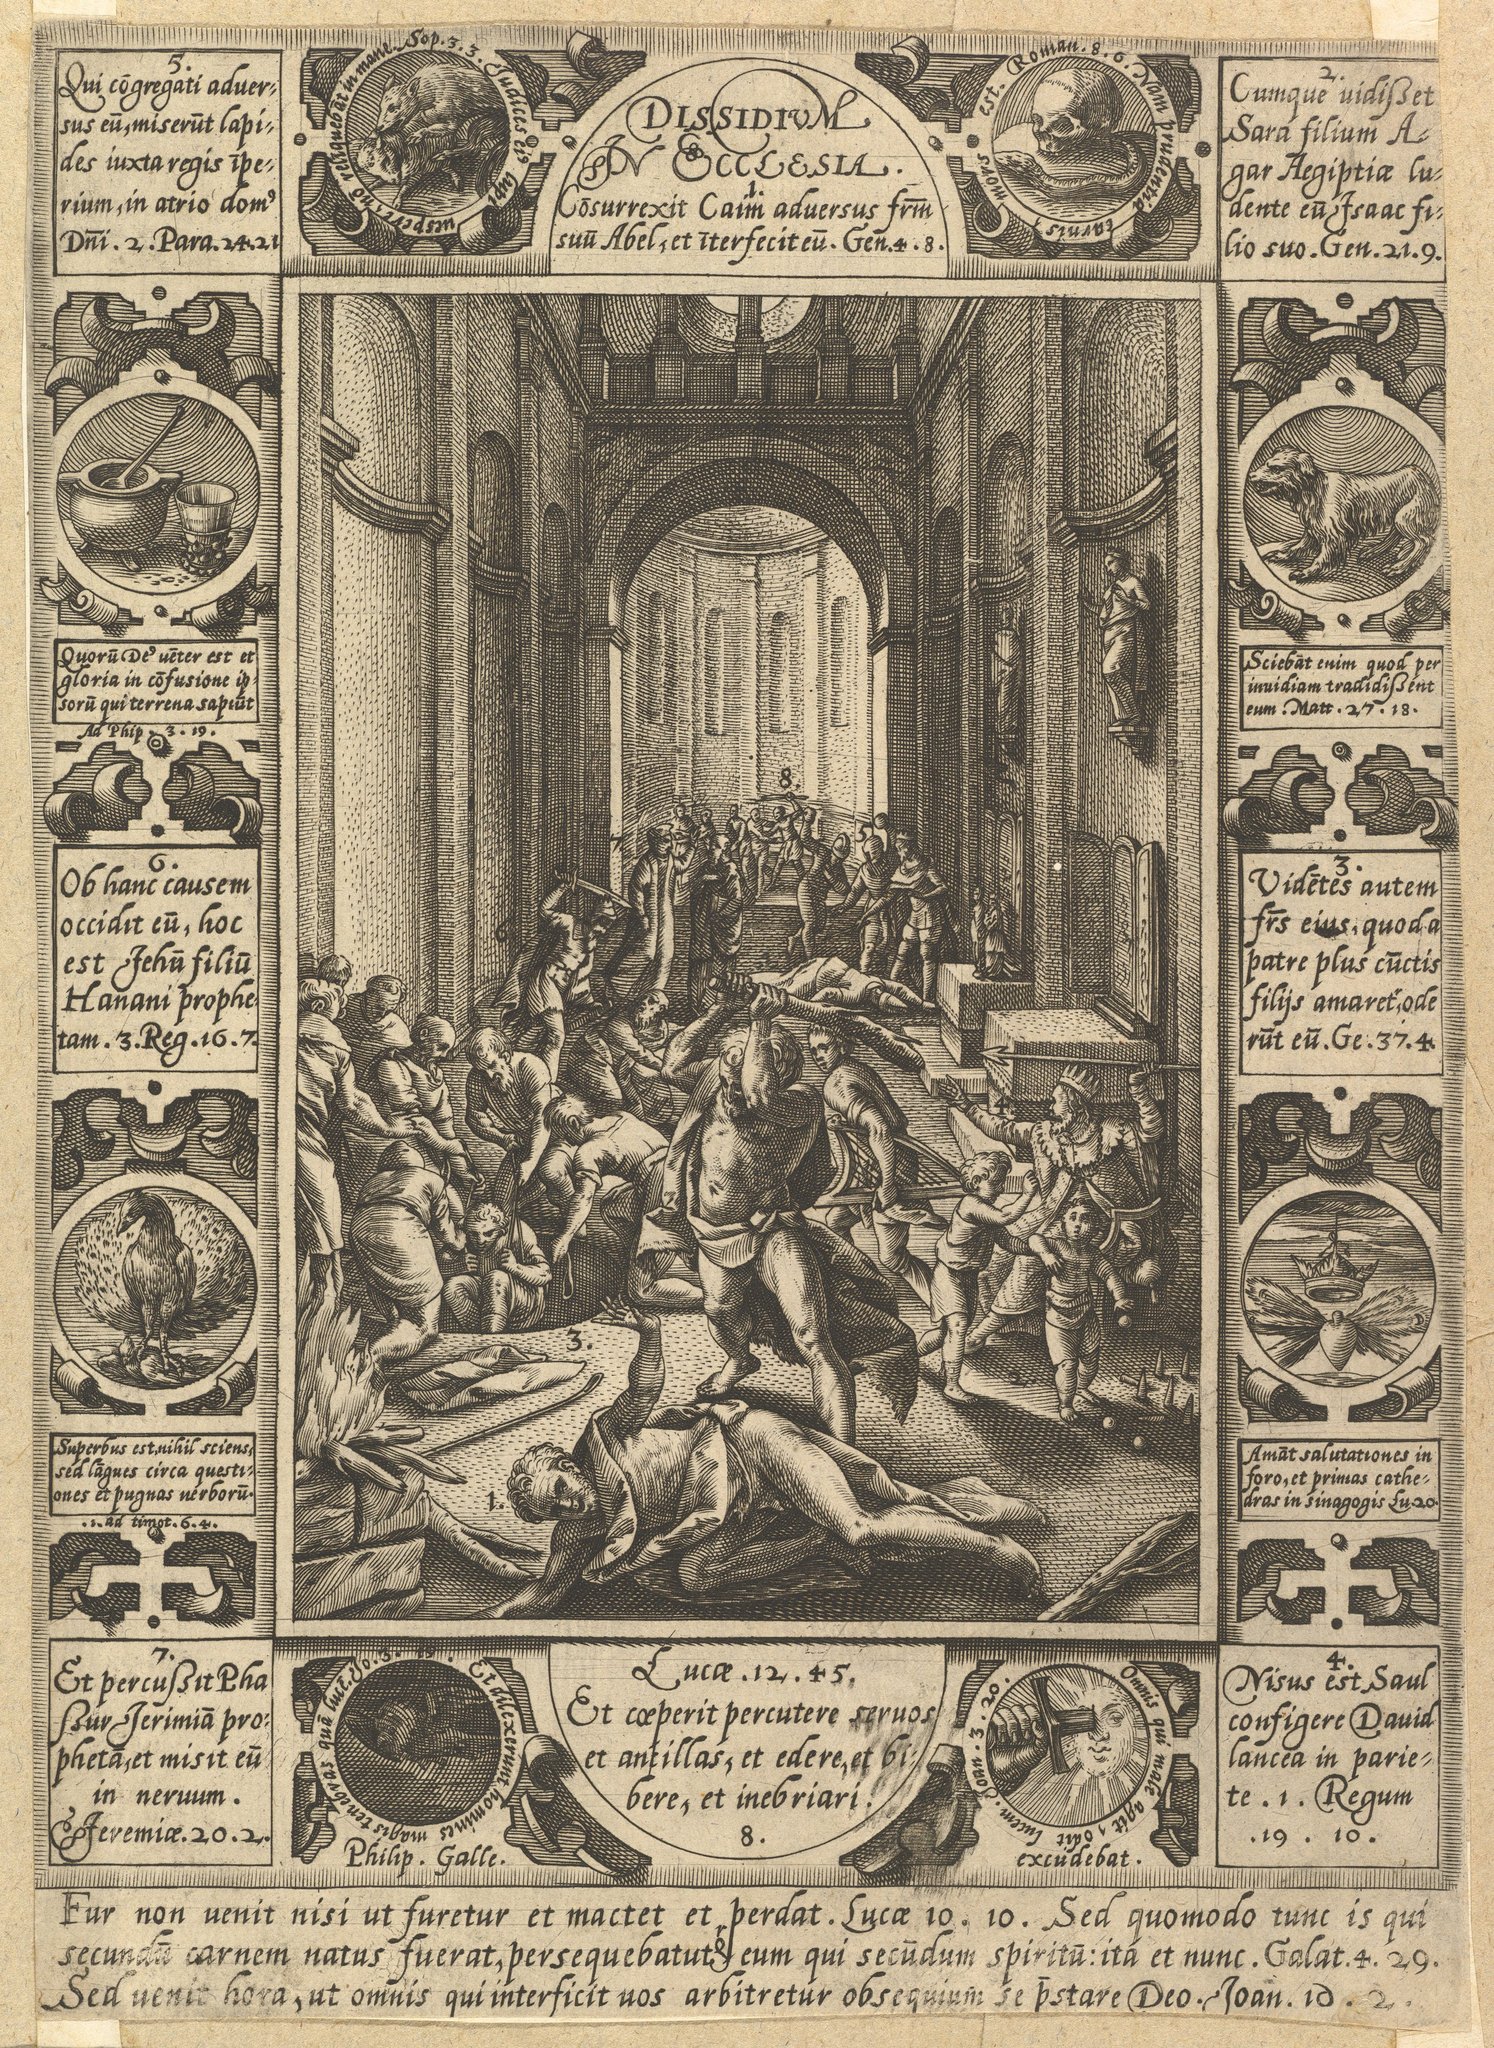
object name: print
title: Dissension in the Church (Dissidium in Ecclesia)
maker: hendrick goltzius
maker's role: artist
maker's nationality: netherlandish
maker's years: 1558-1617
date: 1578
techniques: engraving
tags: churches,men